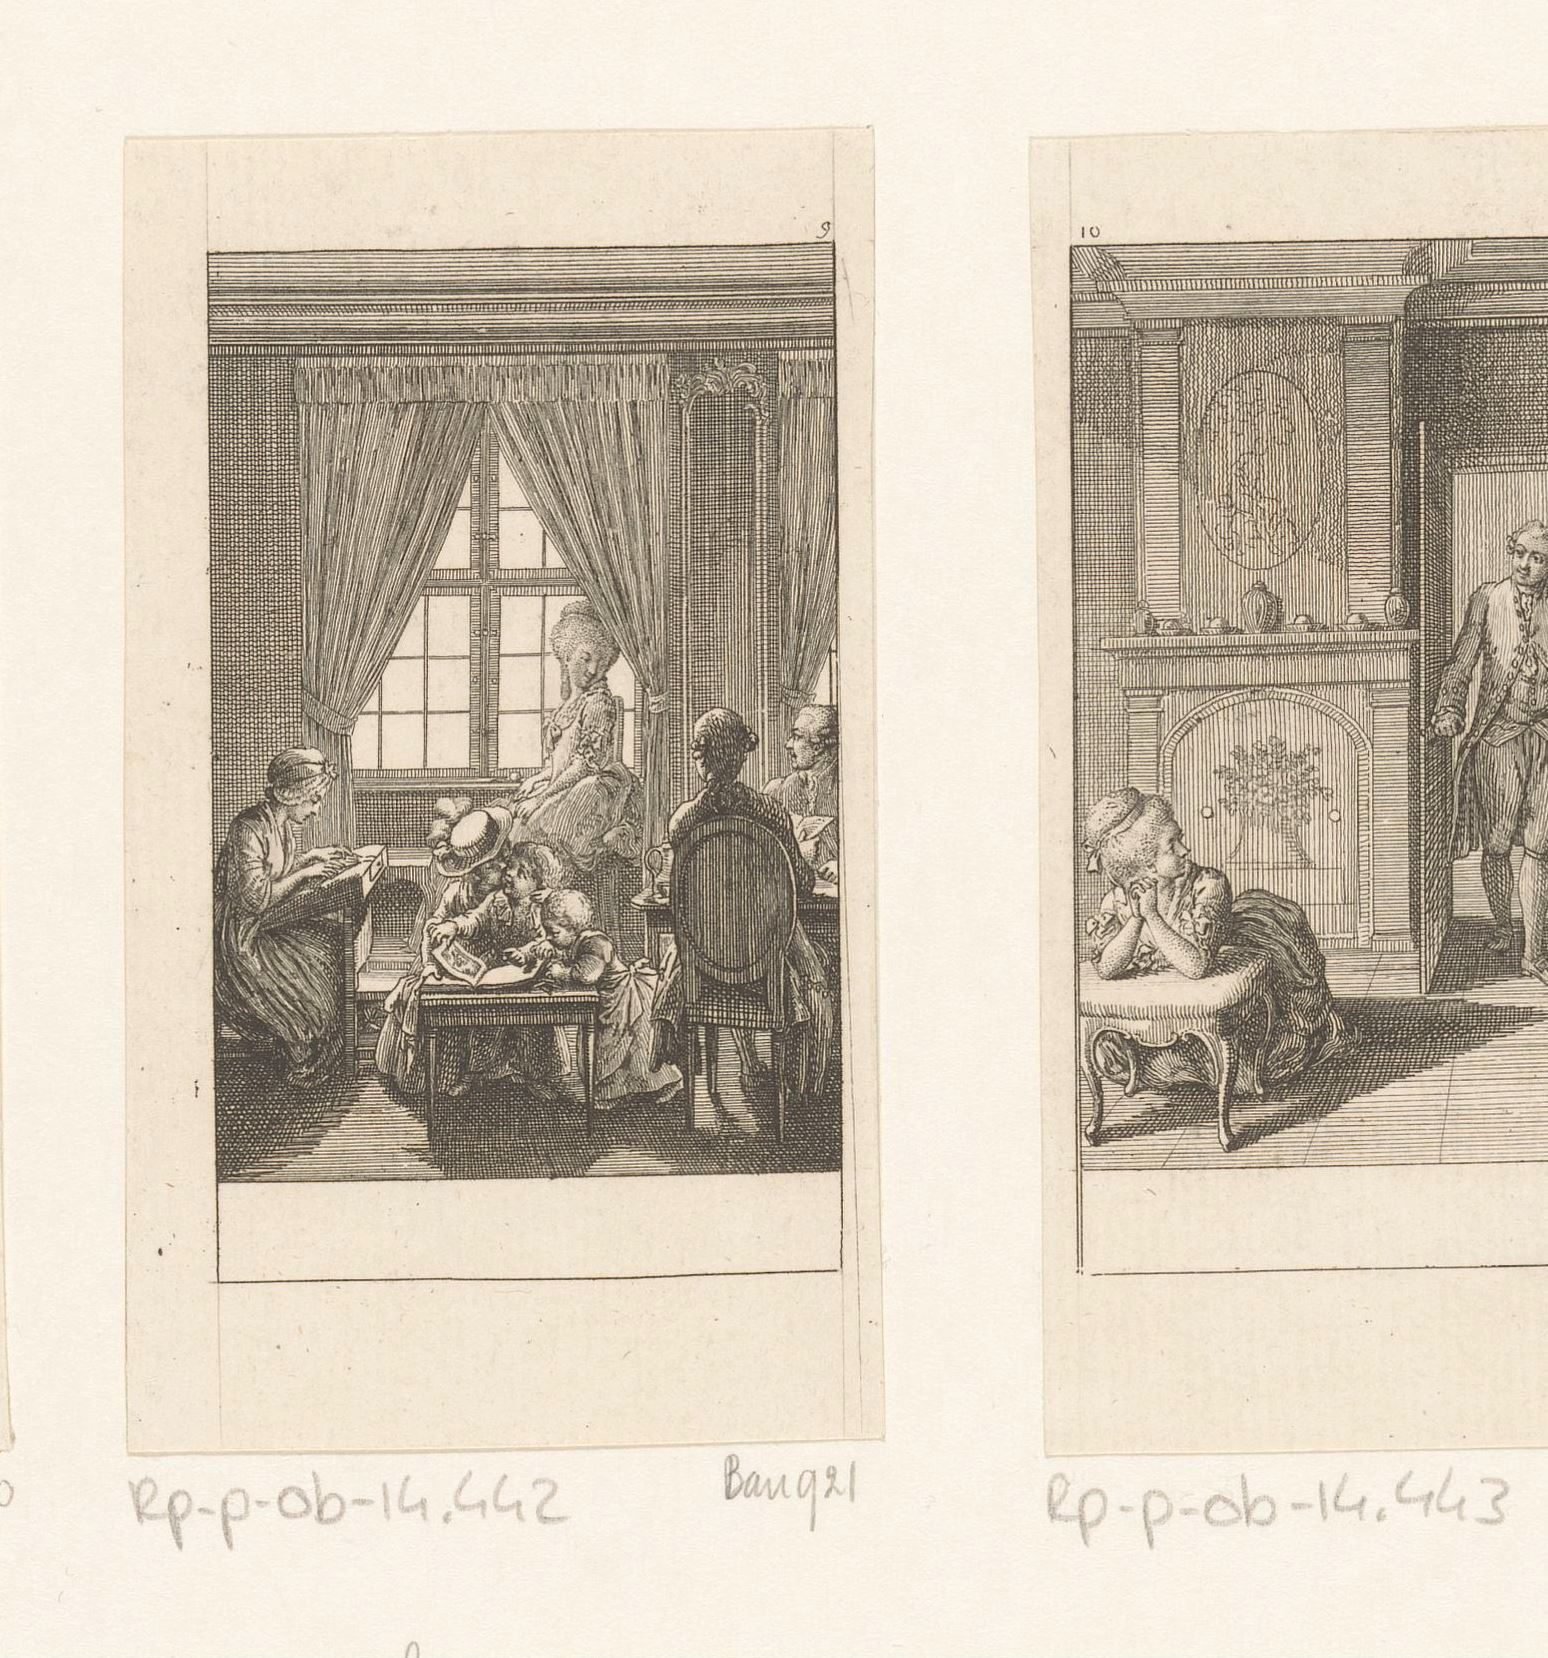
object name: print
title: Rustige middag bij het echtpaar Wolmar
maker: daniel nikolaus chodowiecki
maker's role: draughtsman, print maker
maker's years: 1726-1801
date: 1782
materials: paper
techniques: etching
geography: berlin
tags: parents with their children, human figure at (open) window, interior of the house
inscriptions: collector's mark: Lugt 2228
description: Vervaardigd voor Jean-Jacques Rousseaus 'Neue Héliose'. Latere staat gebruikt voor: Almanac généalogique pour l'année 1783. Berlijn: s.n., 1782.